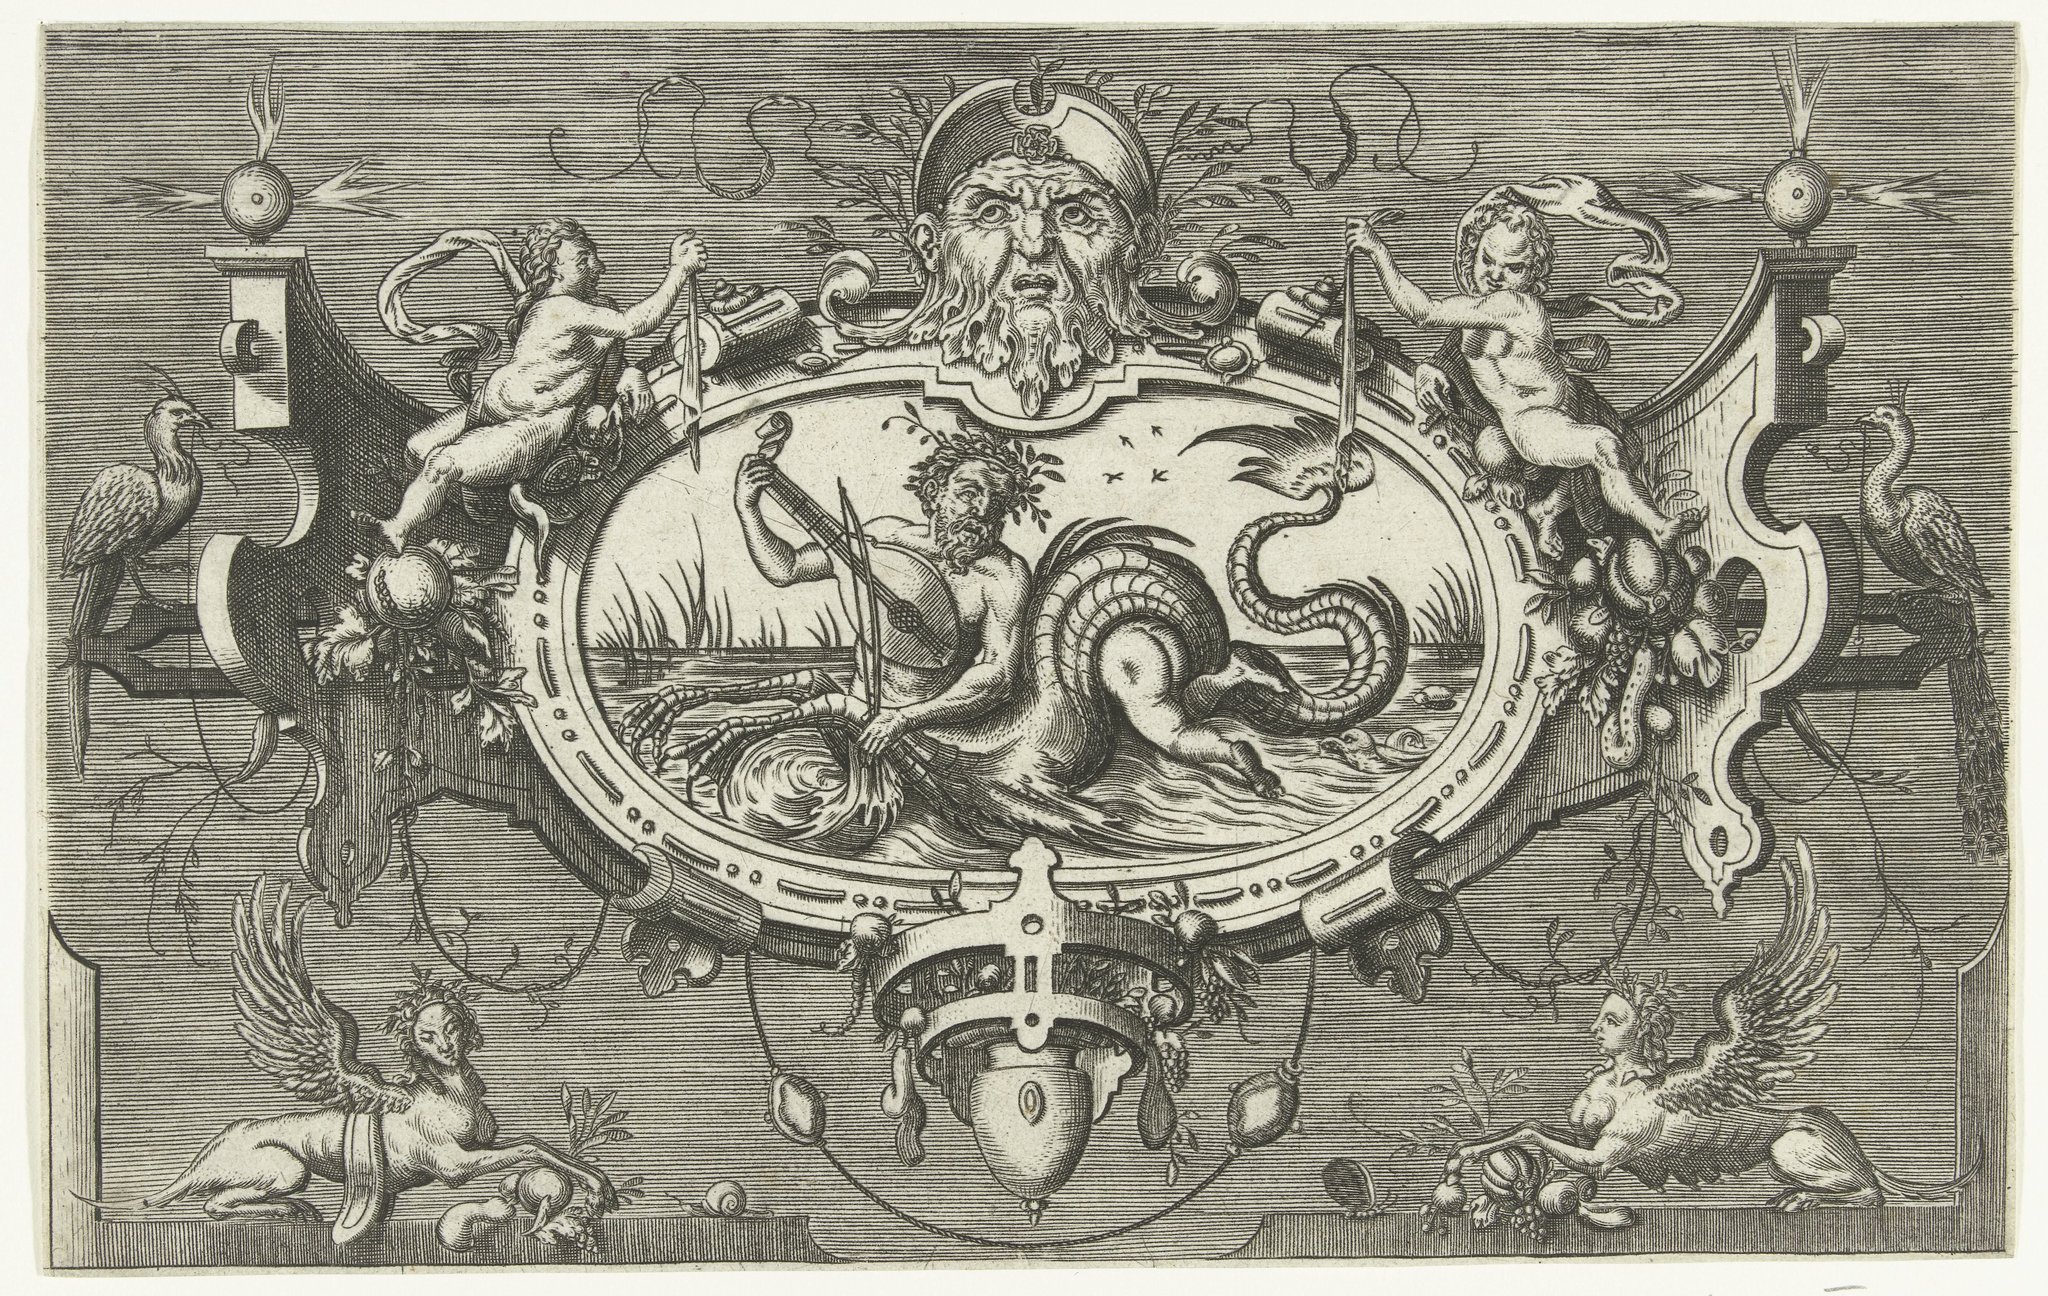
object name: print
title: Veelderhande cierlijcke Compertementen (...)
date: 1564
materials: paper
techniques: engraving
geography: antwerp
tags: sphinx (lion/woman); 'sfinge' (ripa) - aa - female human figure, violin, fiddle, (story of) triton, ornamental birds: peacock, ornament ~ cartouche, mask, mascaron ~ ornament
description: Cartouche met een vedel spelende triton. Zijn staart bedekt een persoon. De cartouche heeft een omlijsting van rolwerk met bovenop een mascaron. Links en rechts een paus en onderaan twee sfinxen. Gearceerde achtergrond. Onderdeel van serie met titelblad en 12 bladen.